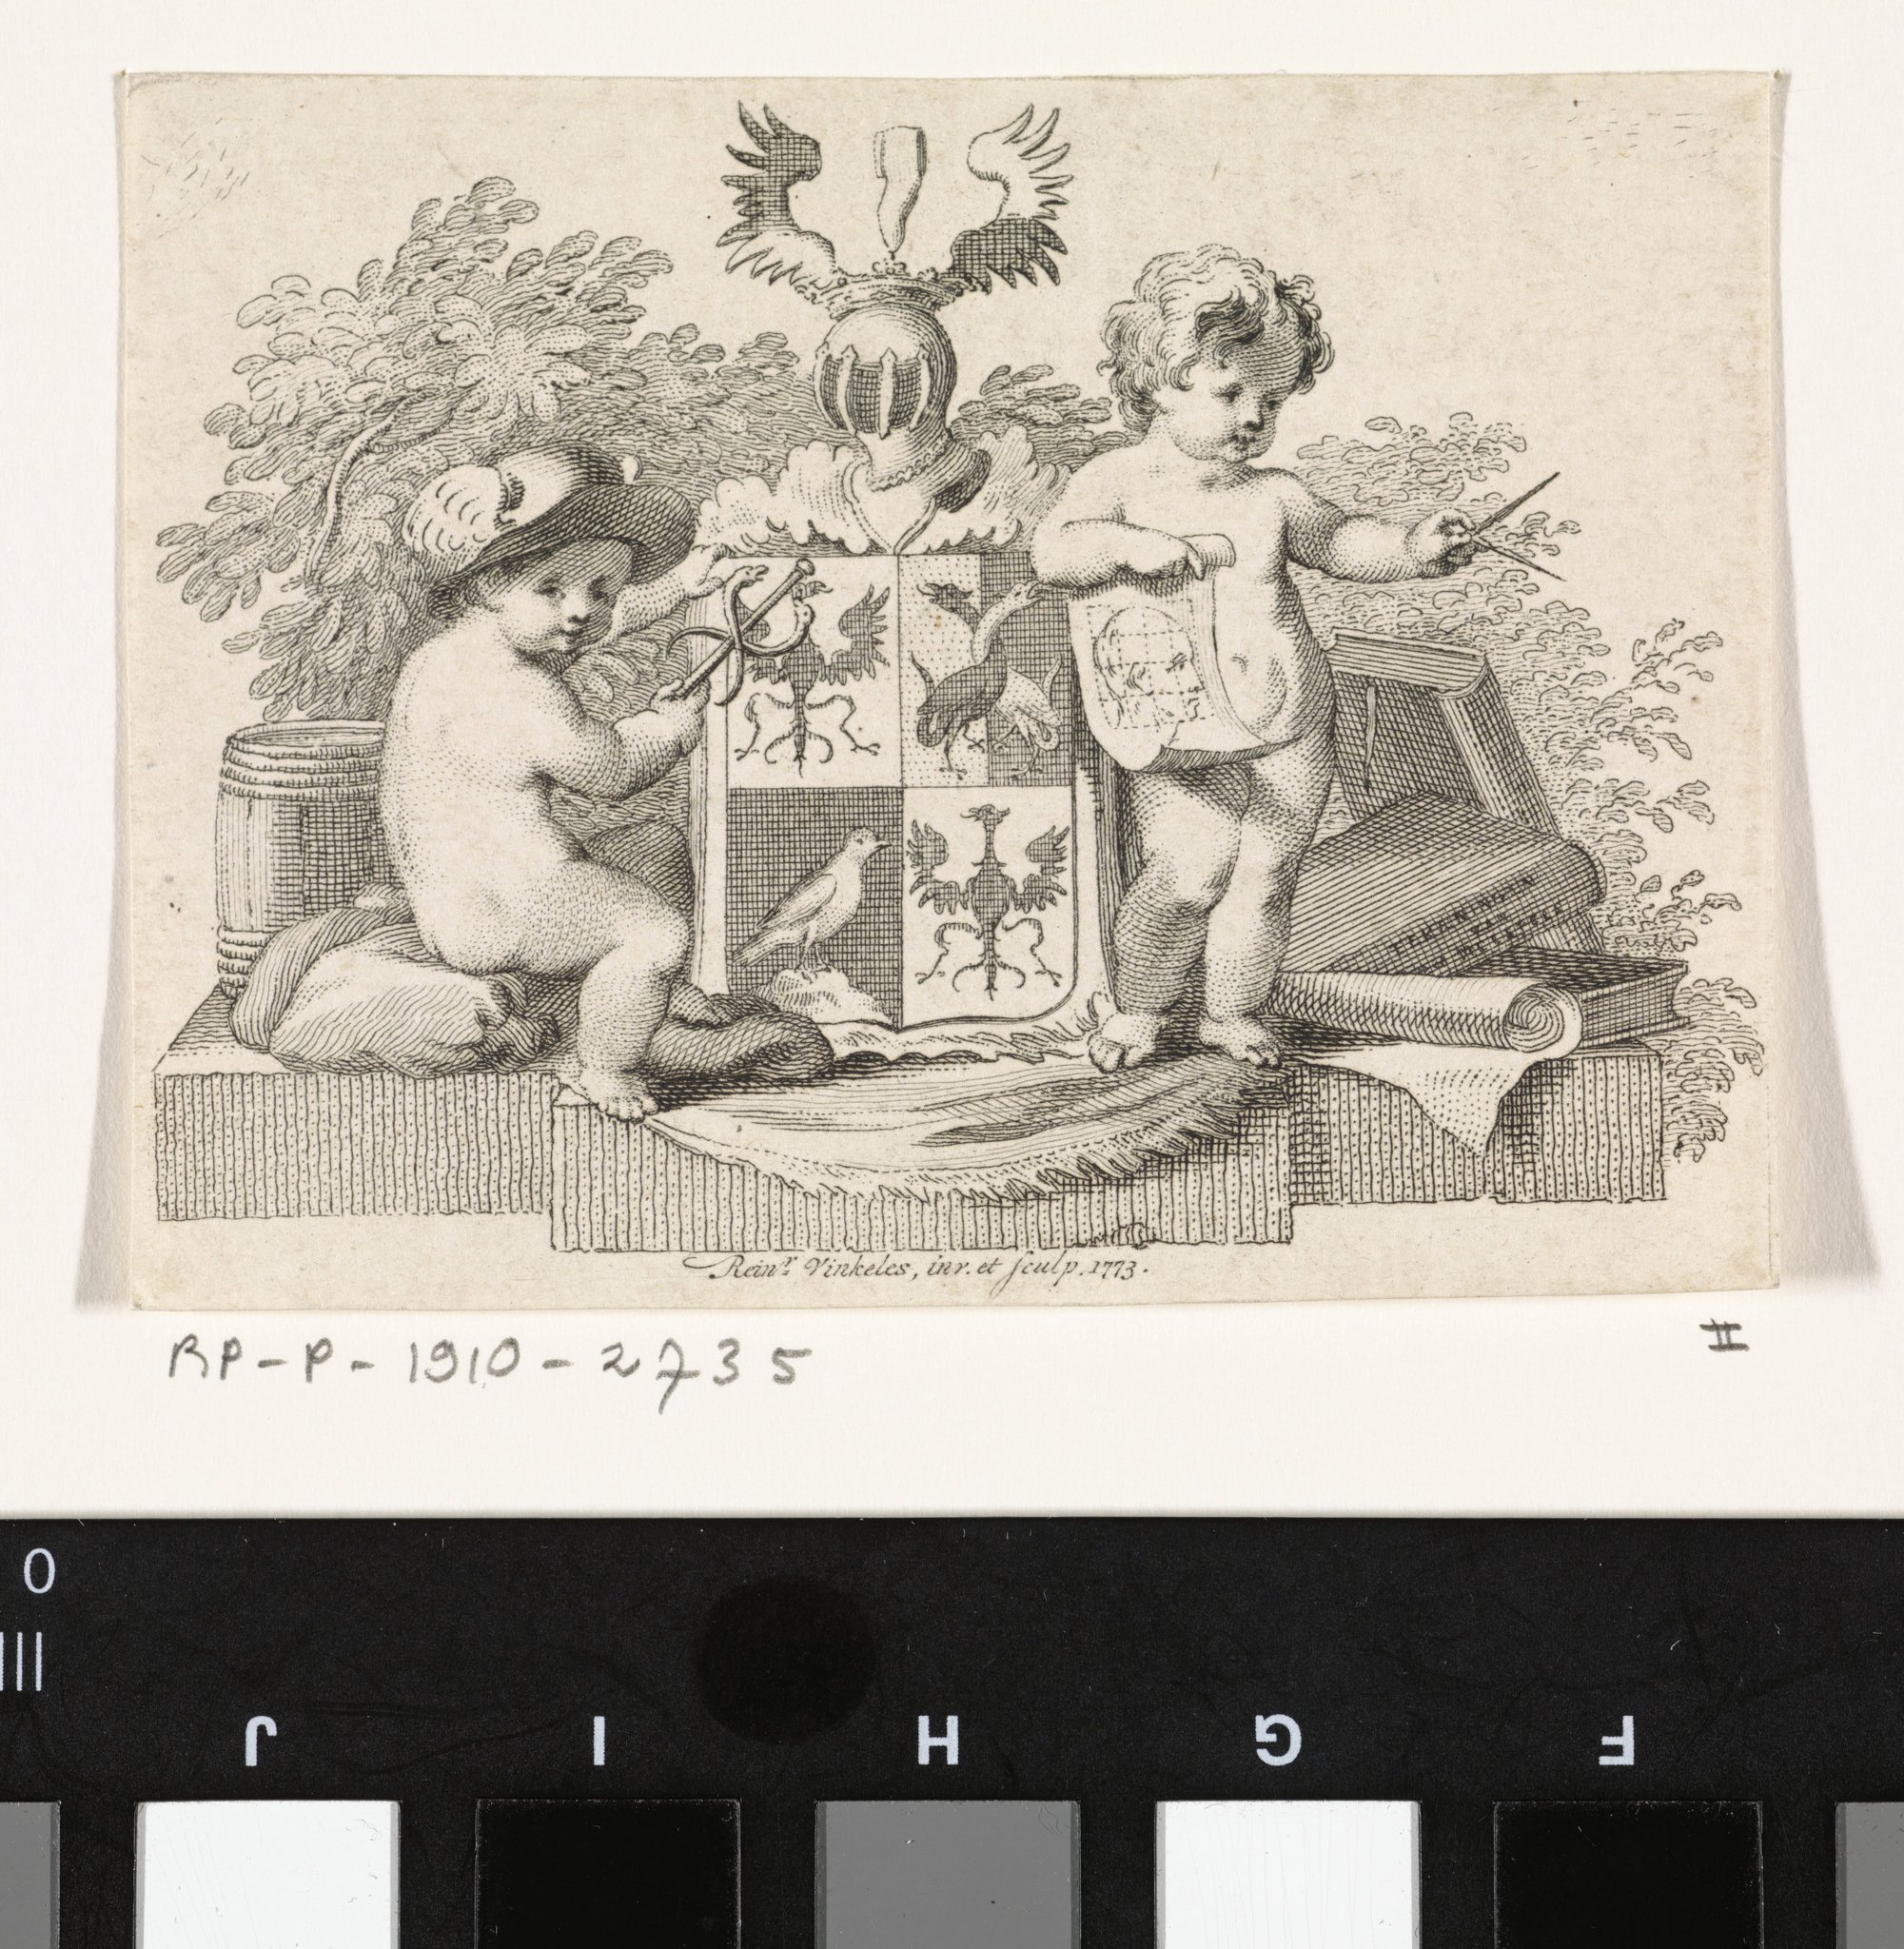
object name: print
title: Familiewapen van Goll van Frankenstein, geflankeerd door twee putti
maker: reinier vinkeles (i)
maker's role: draughtsman, print maker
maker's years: 1741-1816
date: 1773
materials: paper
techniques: engraving, etching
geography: amsterdam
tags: compasses, attributes of mercury, cupids: 'amores', 'amoretti', 'putti'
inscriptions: collector's mark: Lugt 2228